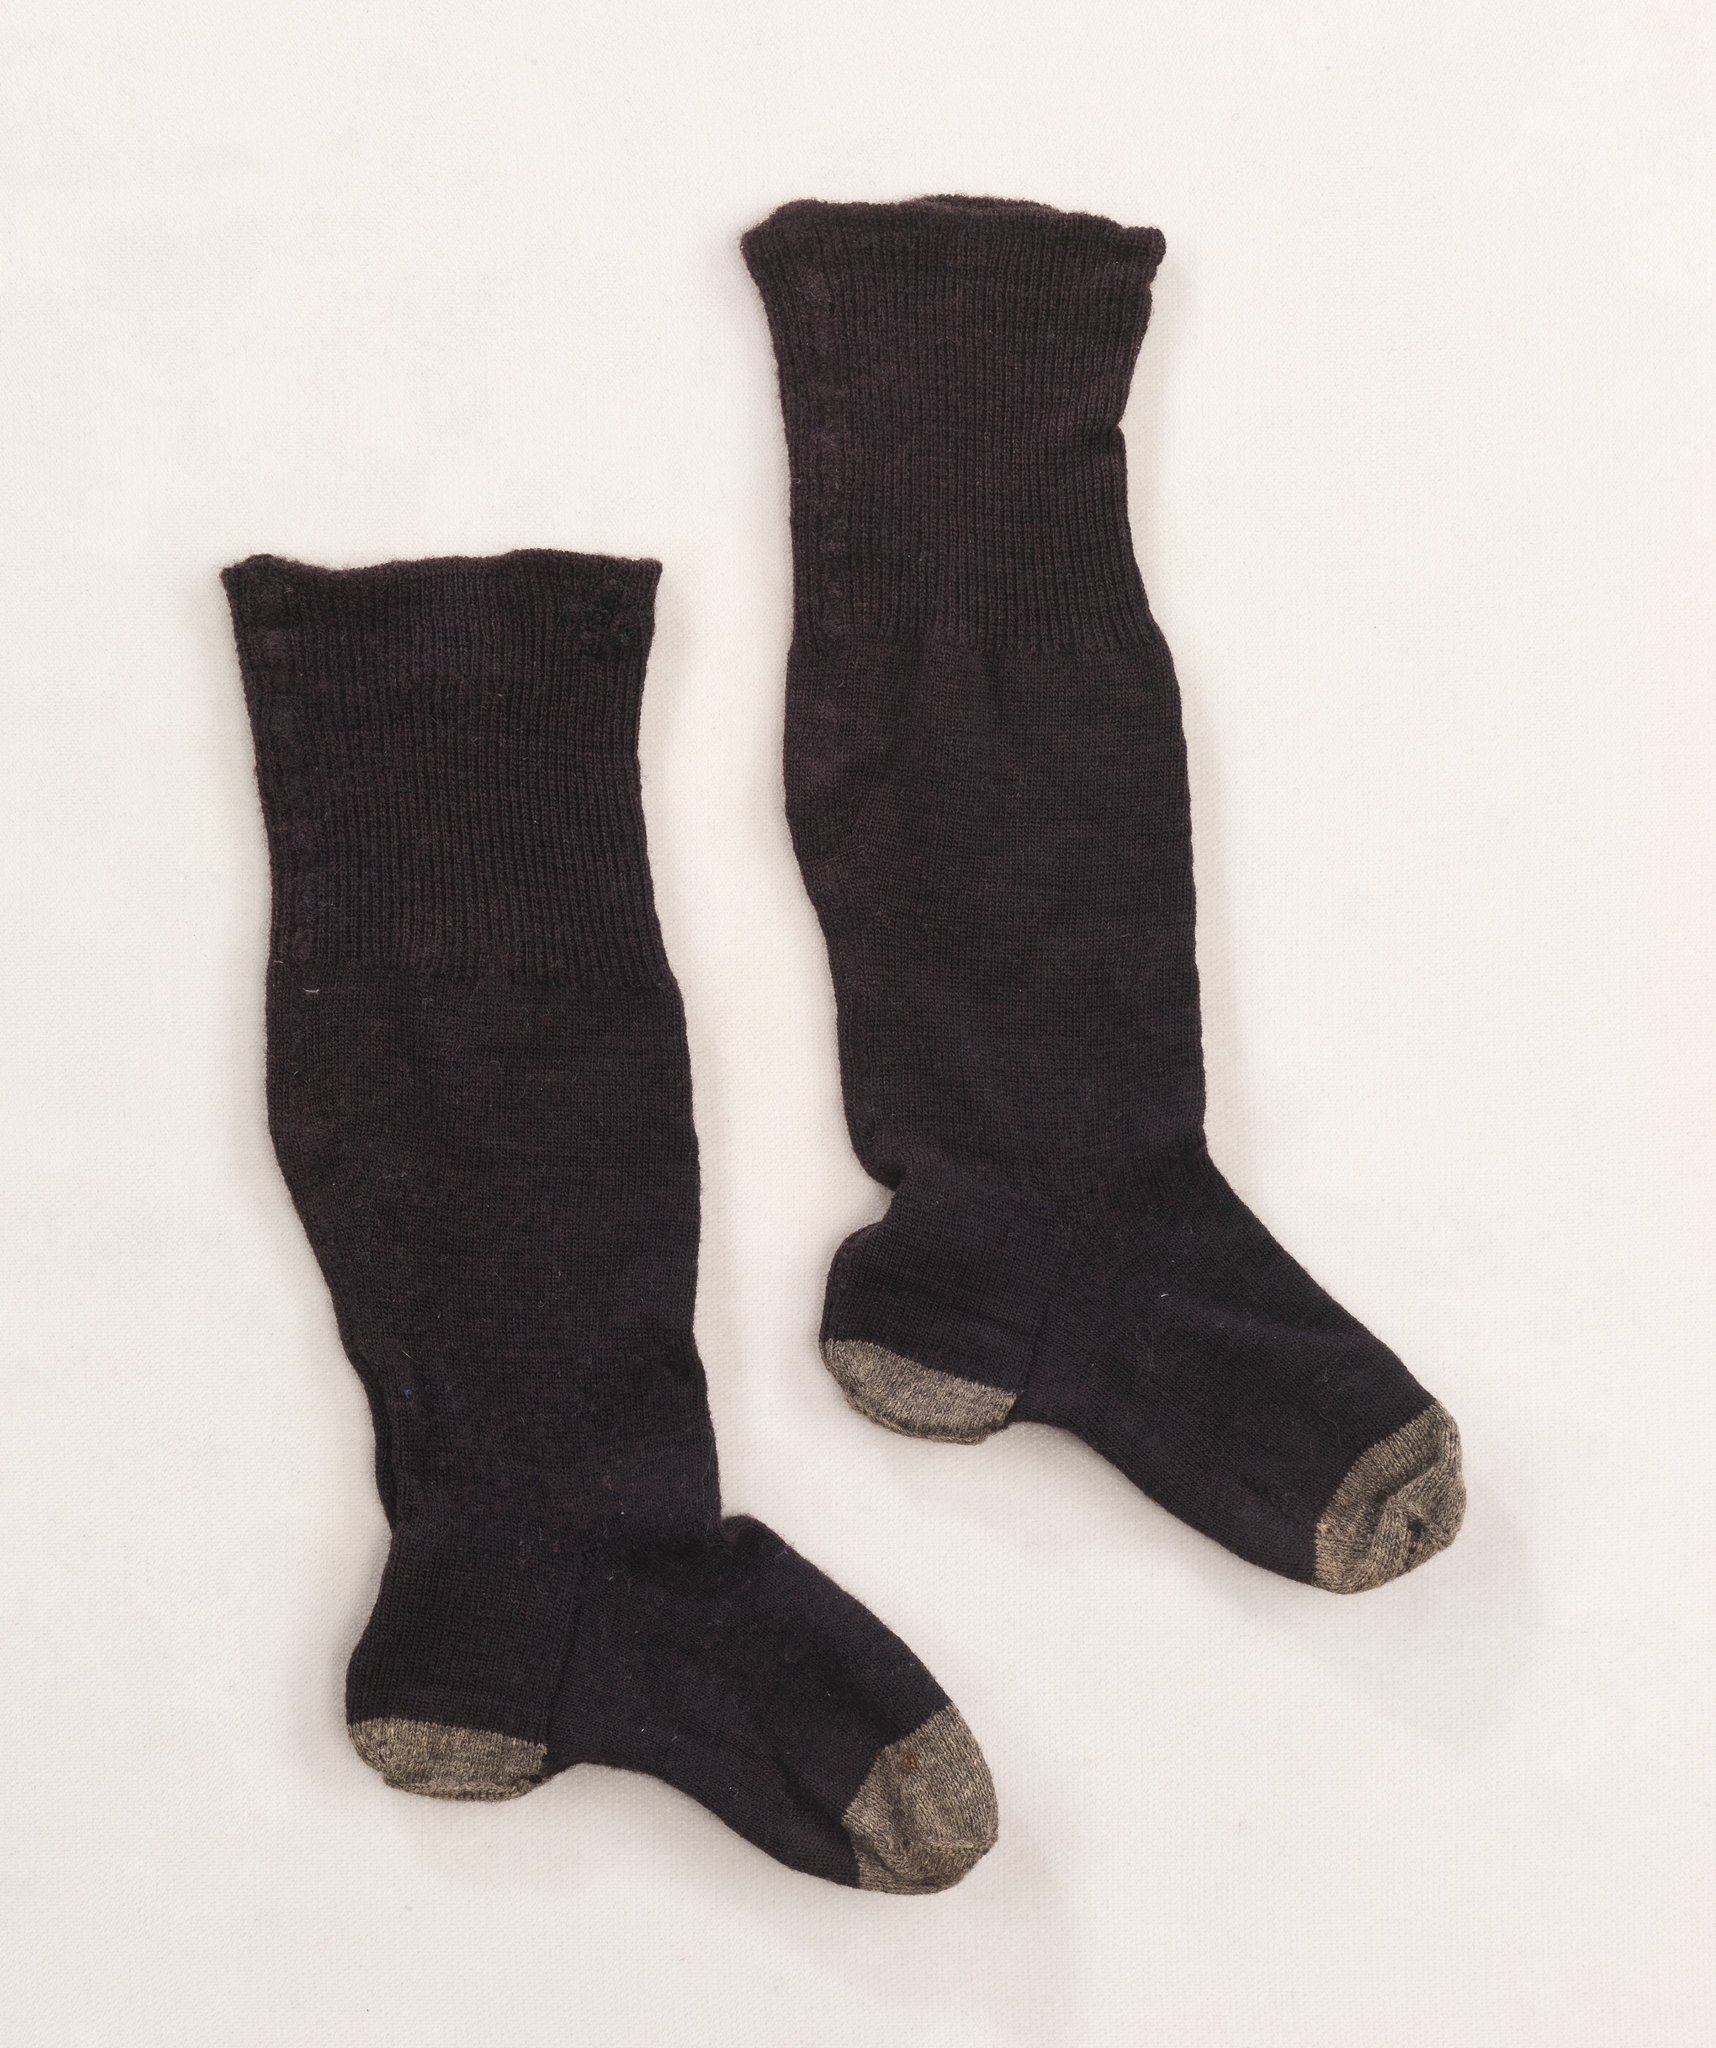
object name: stocking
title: Stockings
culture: american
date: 1892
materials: cotton